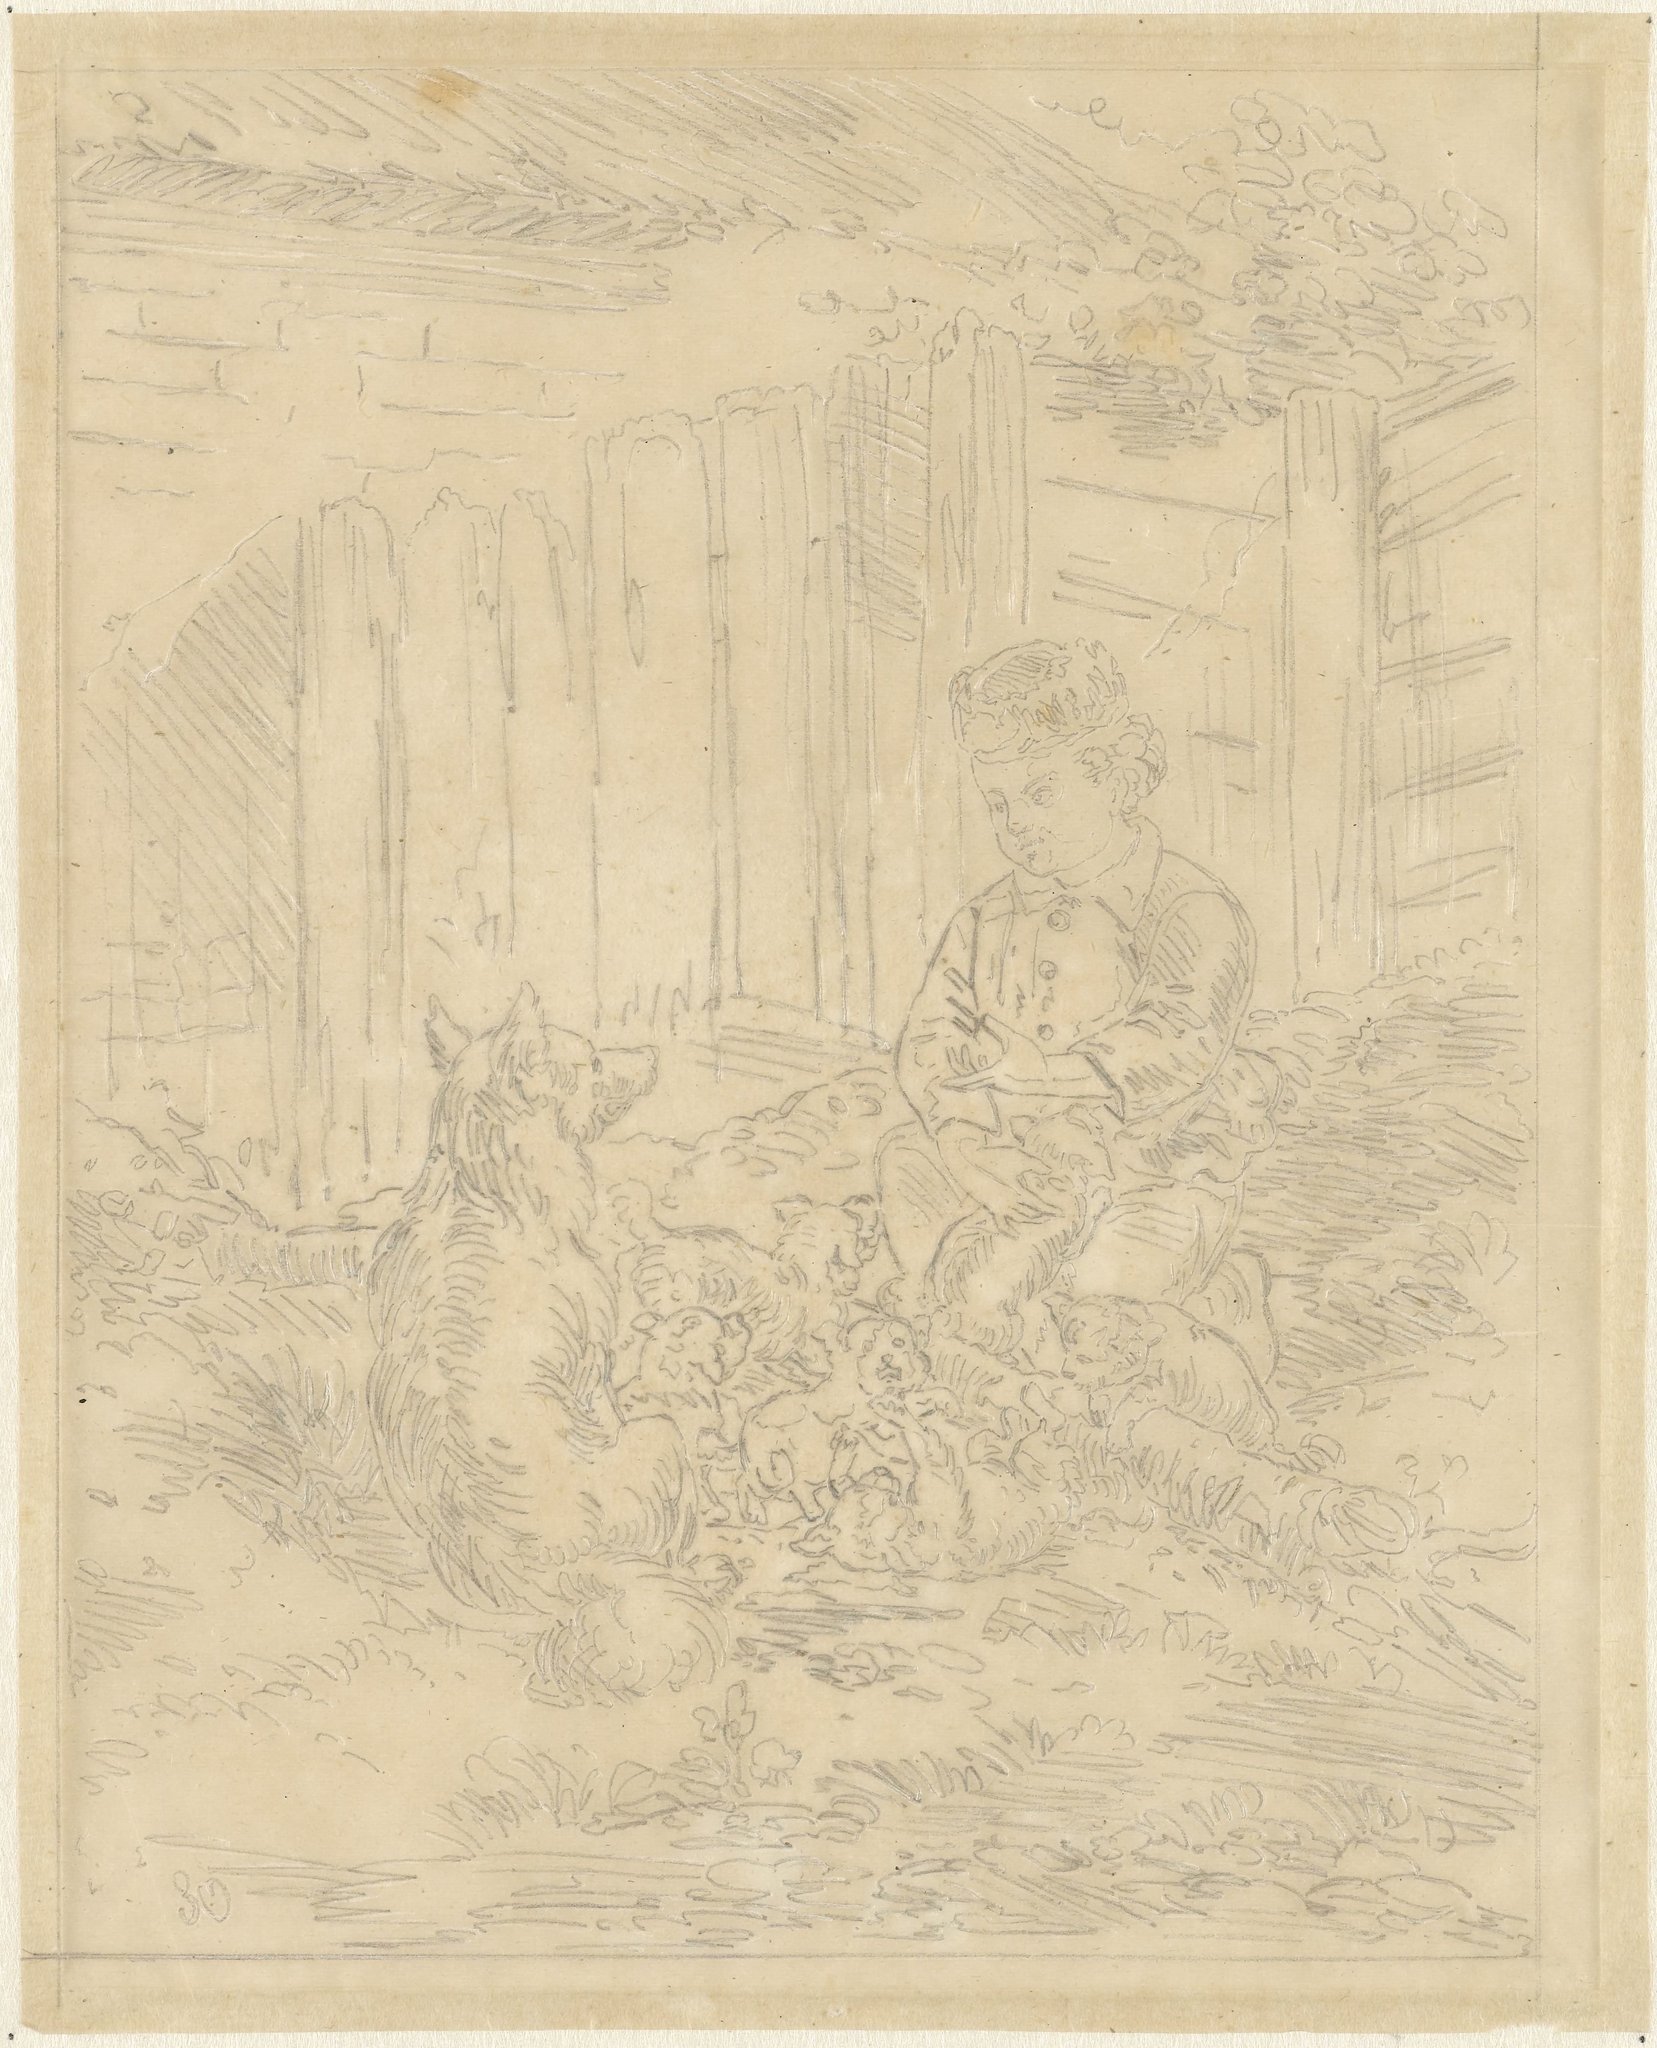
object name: drawing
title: Kind met honden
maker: otto eerelman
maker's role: draughtsman, painter, print maker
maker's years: 1839-1926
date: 1865-1918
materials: paper, pencil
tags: child, dog